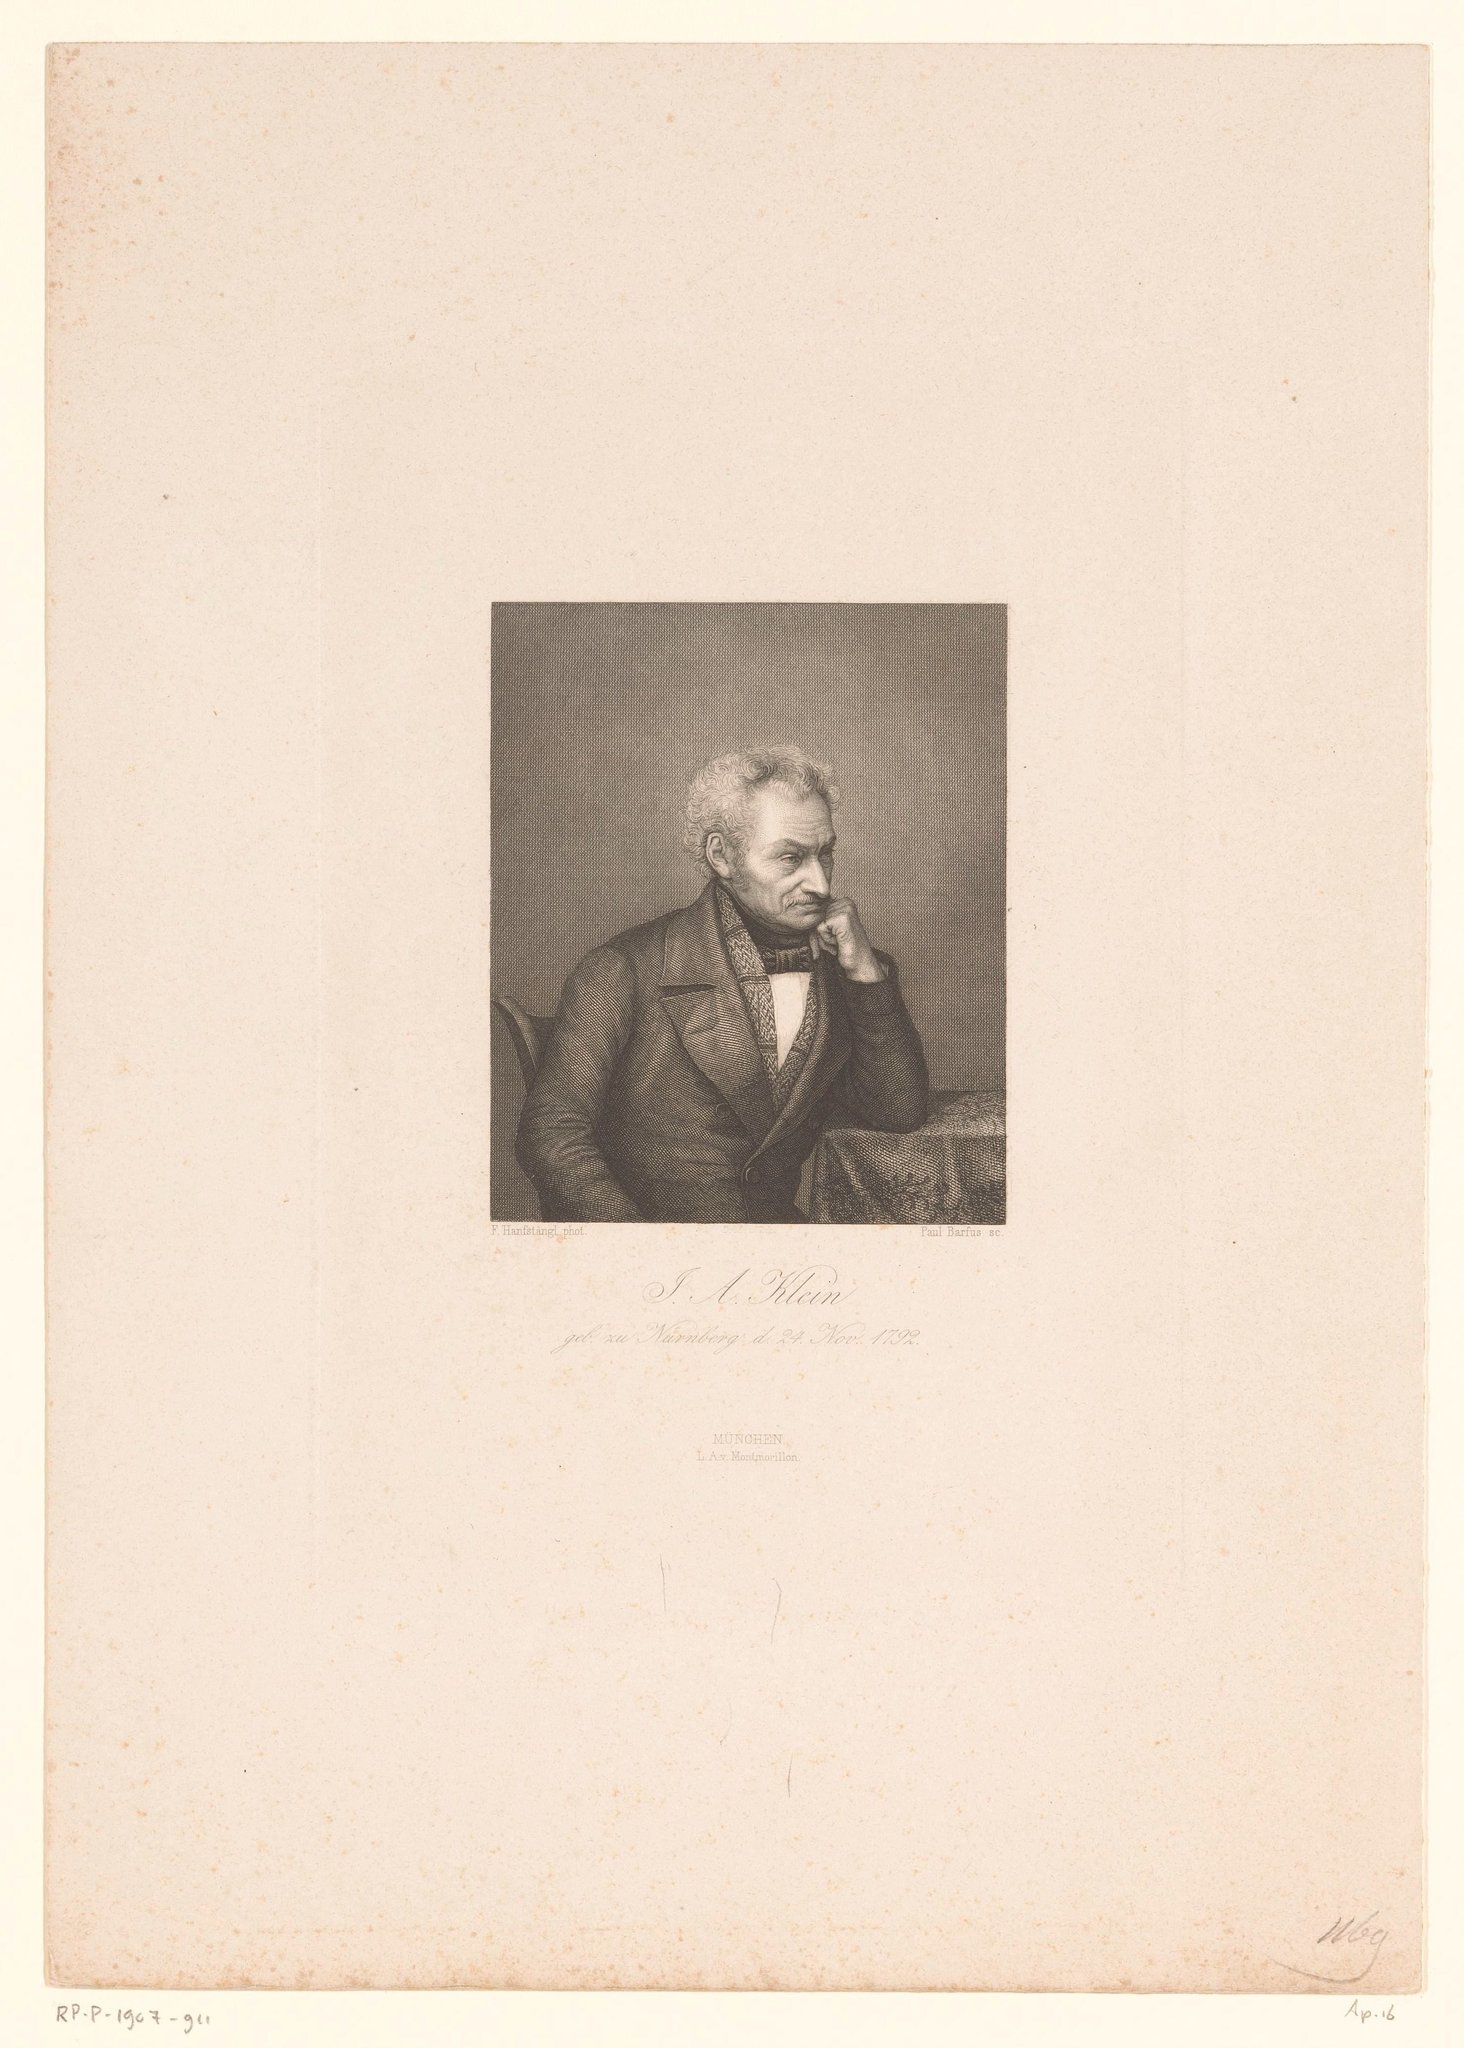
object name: print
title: Portret van Johann Adam Klein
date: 1834-1854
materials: paper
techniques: engraving, etching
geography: munich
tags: print maker, draughtsman, johann adam klein, portrait, self-portrait of artist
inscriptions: collector's mark: Lugt 2228